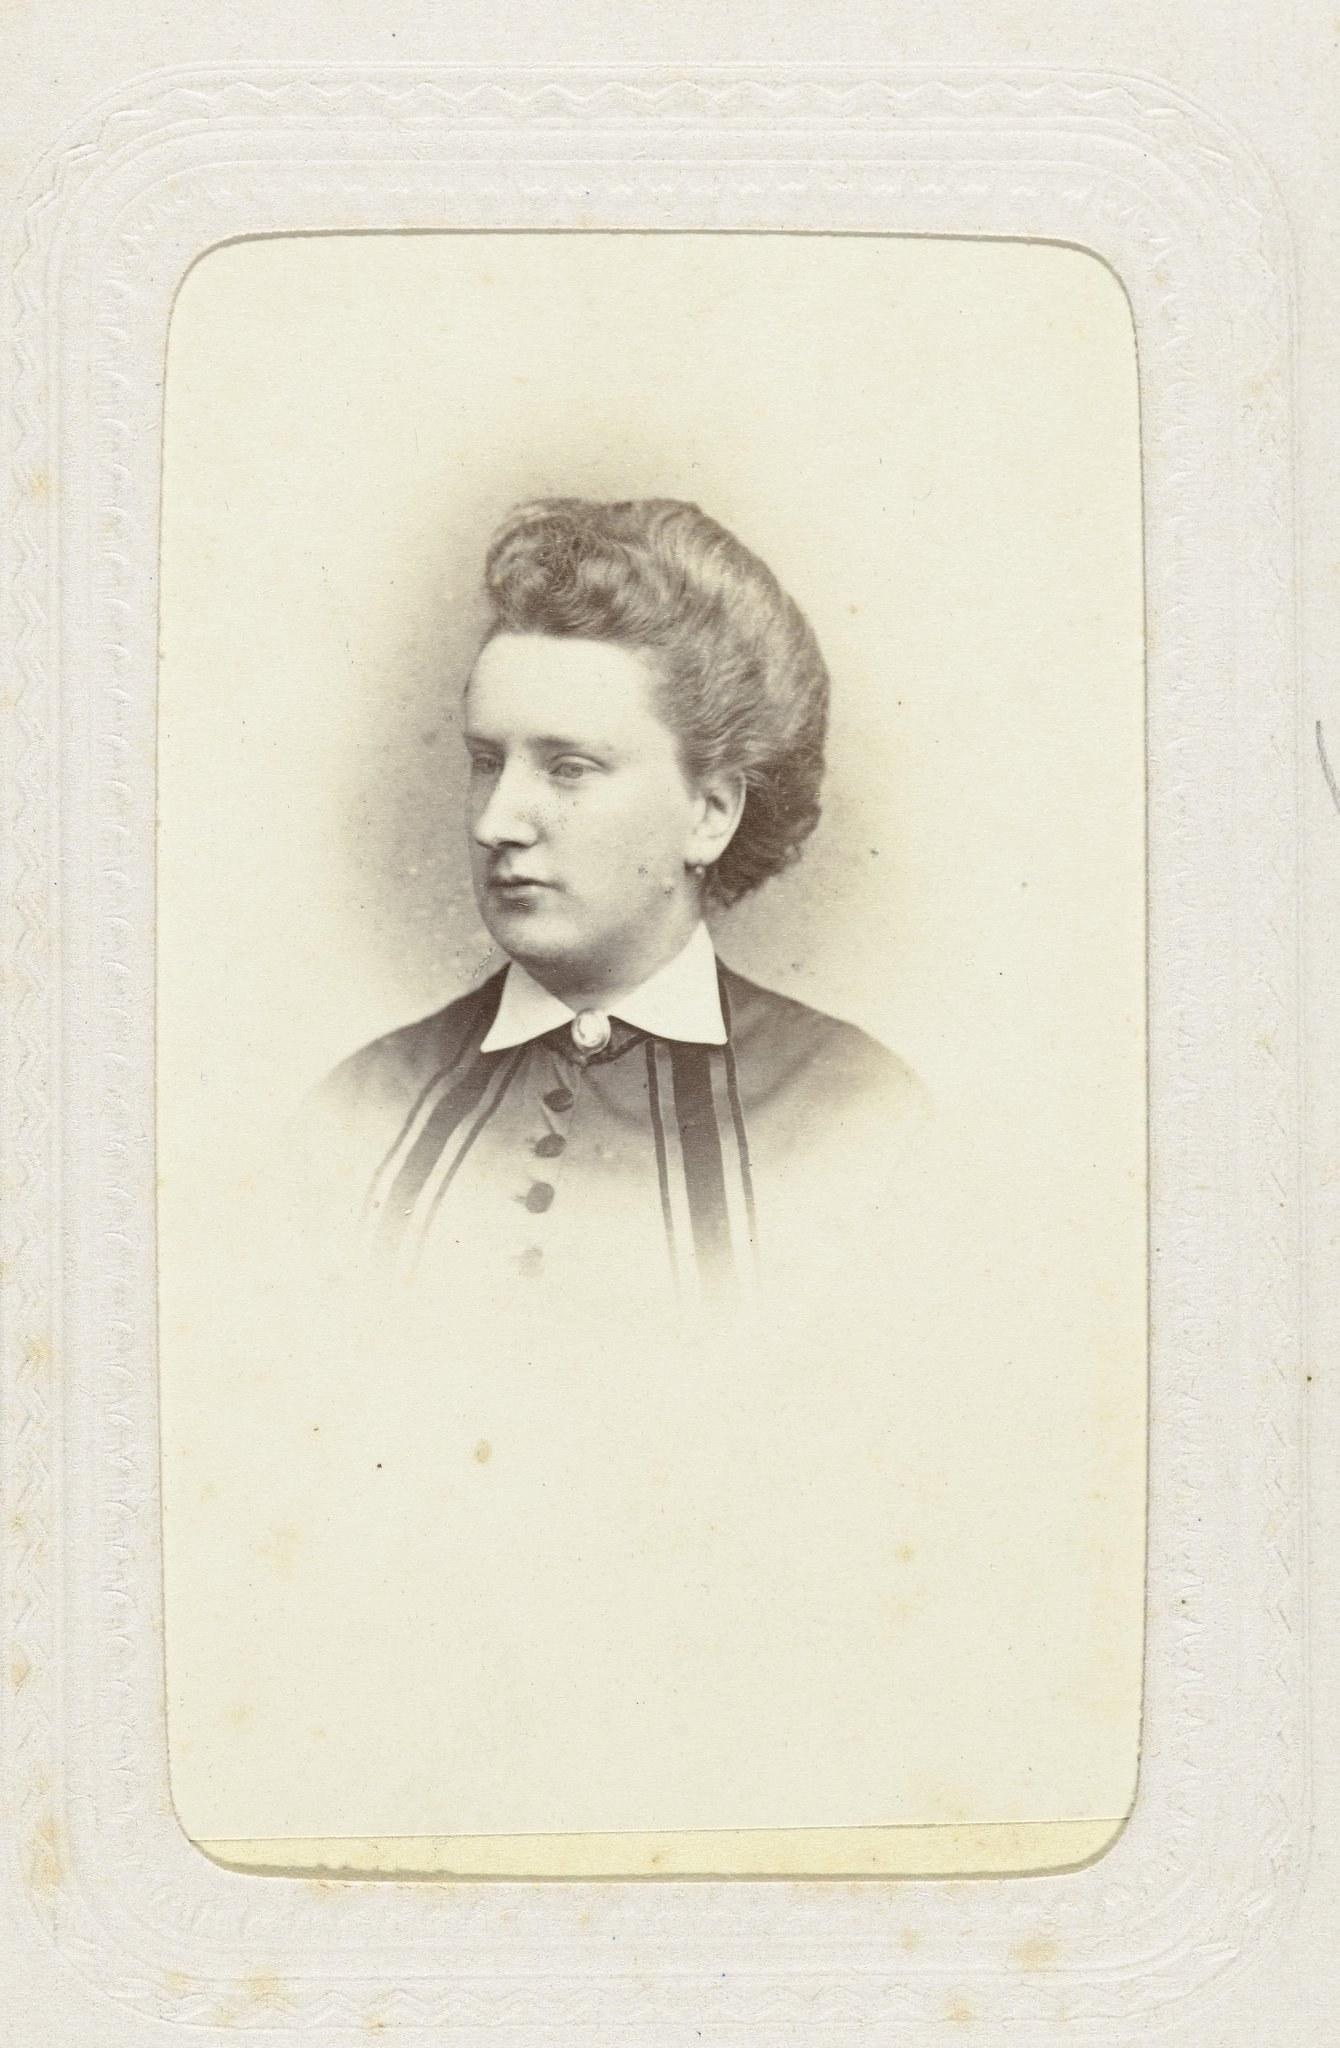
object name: carte de visite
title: Studioportret van een vrouw met opgestoken haar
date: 1863-1870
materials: cardboard, paper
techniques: albumen print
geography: amsterdam